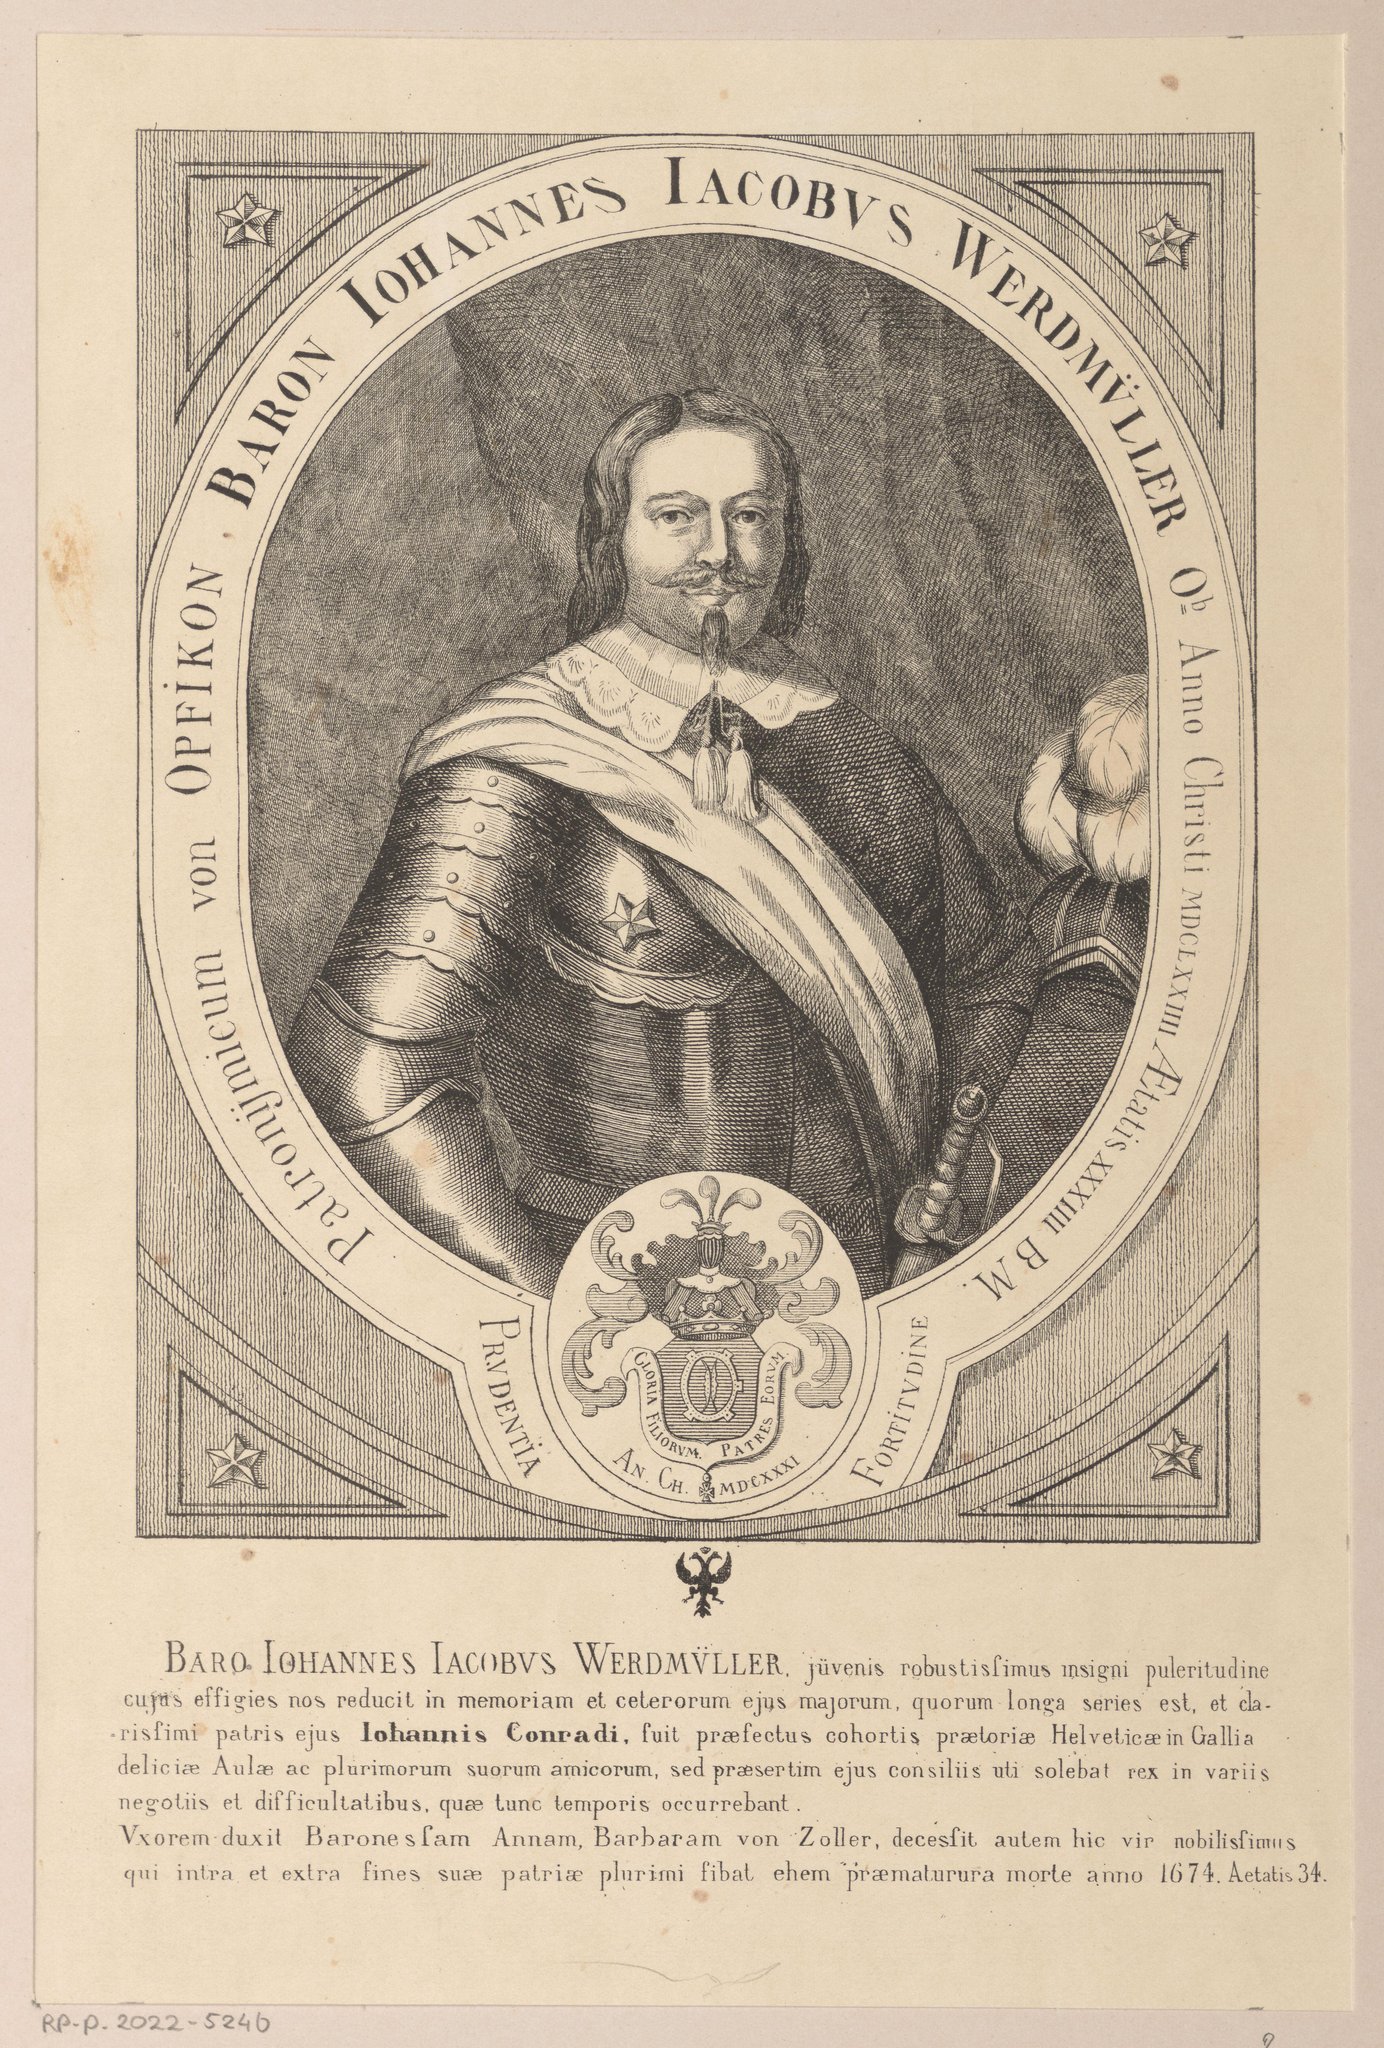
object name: print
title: Portret van Johann Jacob Werdmüller von Elgg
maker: Anonymous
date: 1850-1900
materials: paper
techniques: lithograph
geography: switzerland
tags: armour, historical persons, hacking and thrusting weapons: sword, armorial bearing, heraldry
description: Met zevenregelig onderschrift in het Latijn.